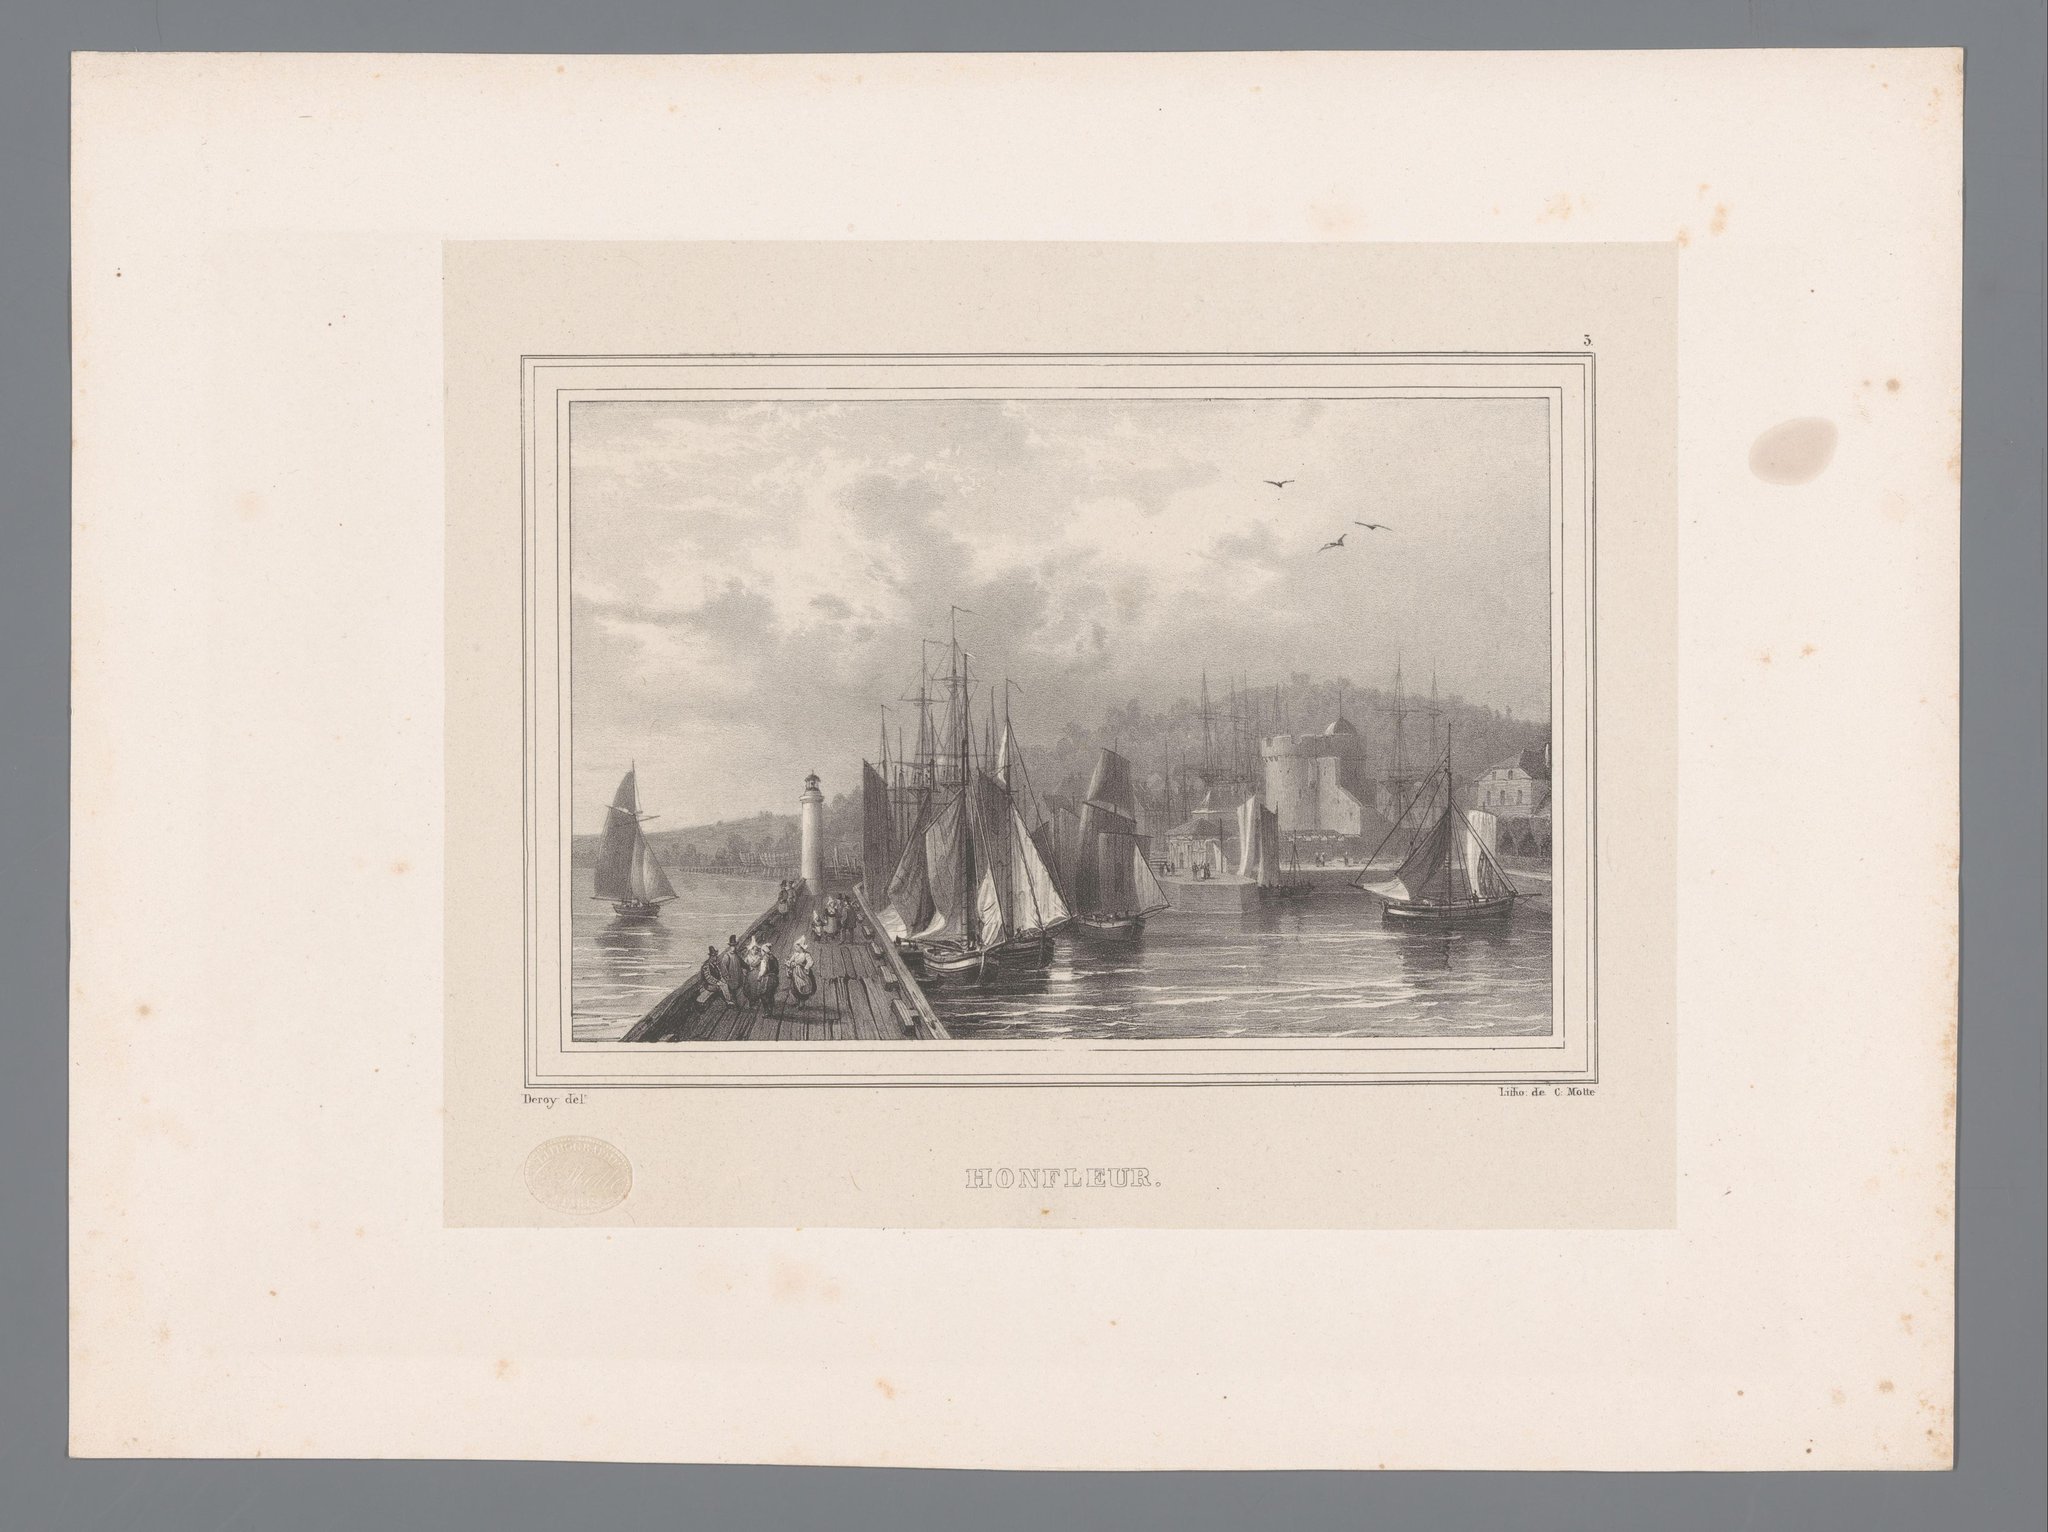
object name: print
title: Les Rives de la Seine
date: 1829-1831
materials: paper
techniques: lithograph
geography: paris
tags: pier, quay, wharf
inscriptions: check stamp: Lugt 1828b, collector's mark: Lugt 2228a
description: Prent maakt deel uit van een omslag met veertien prenten.